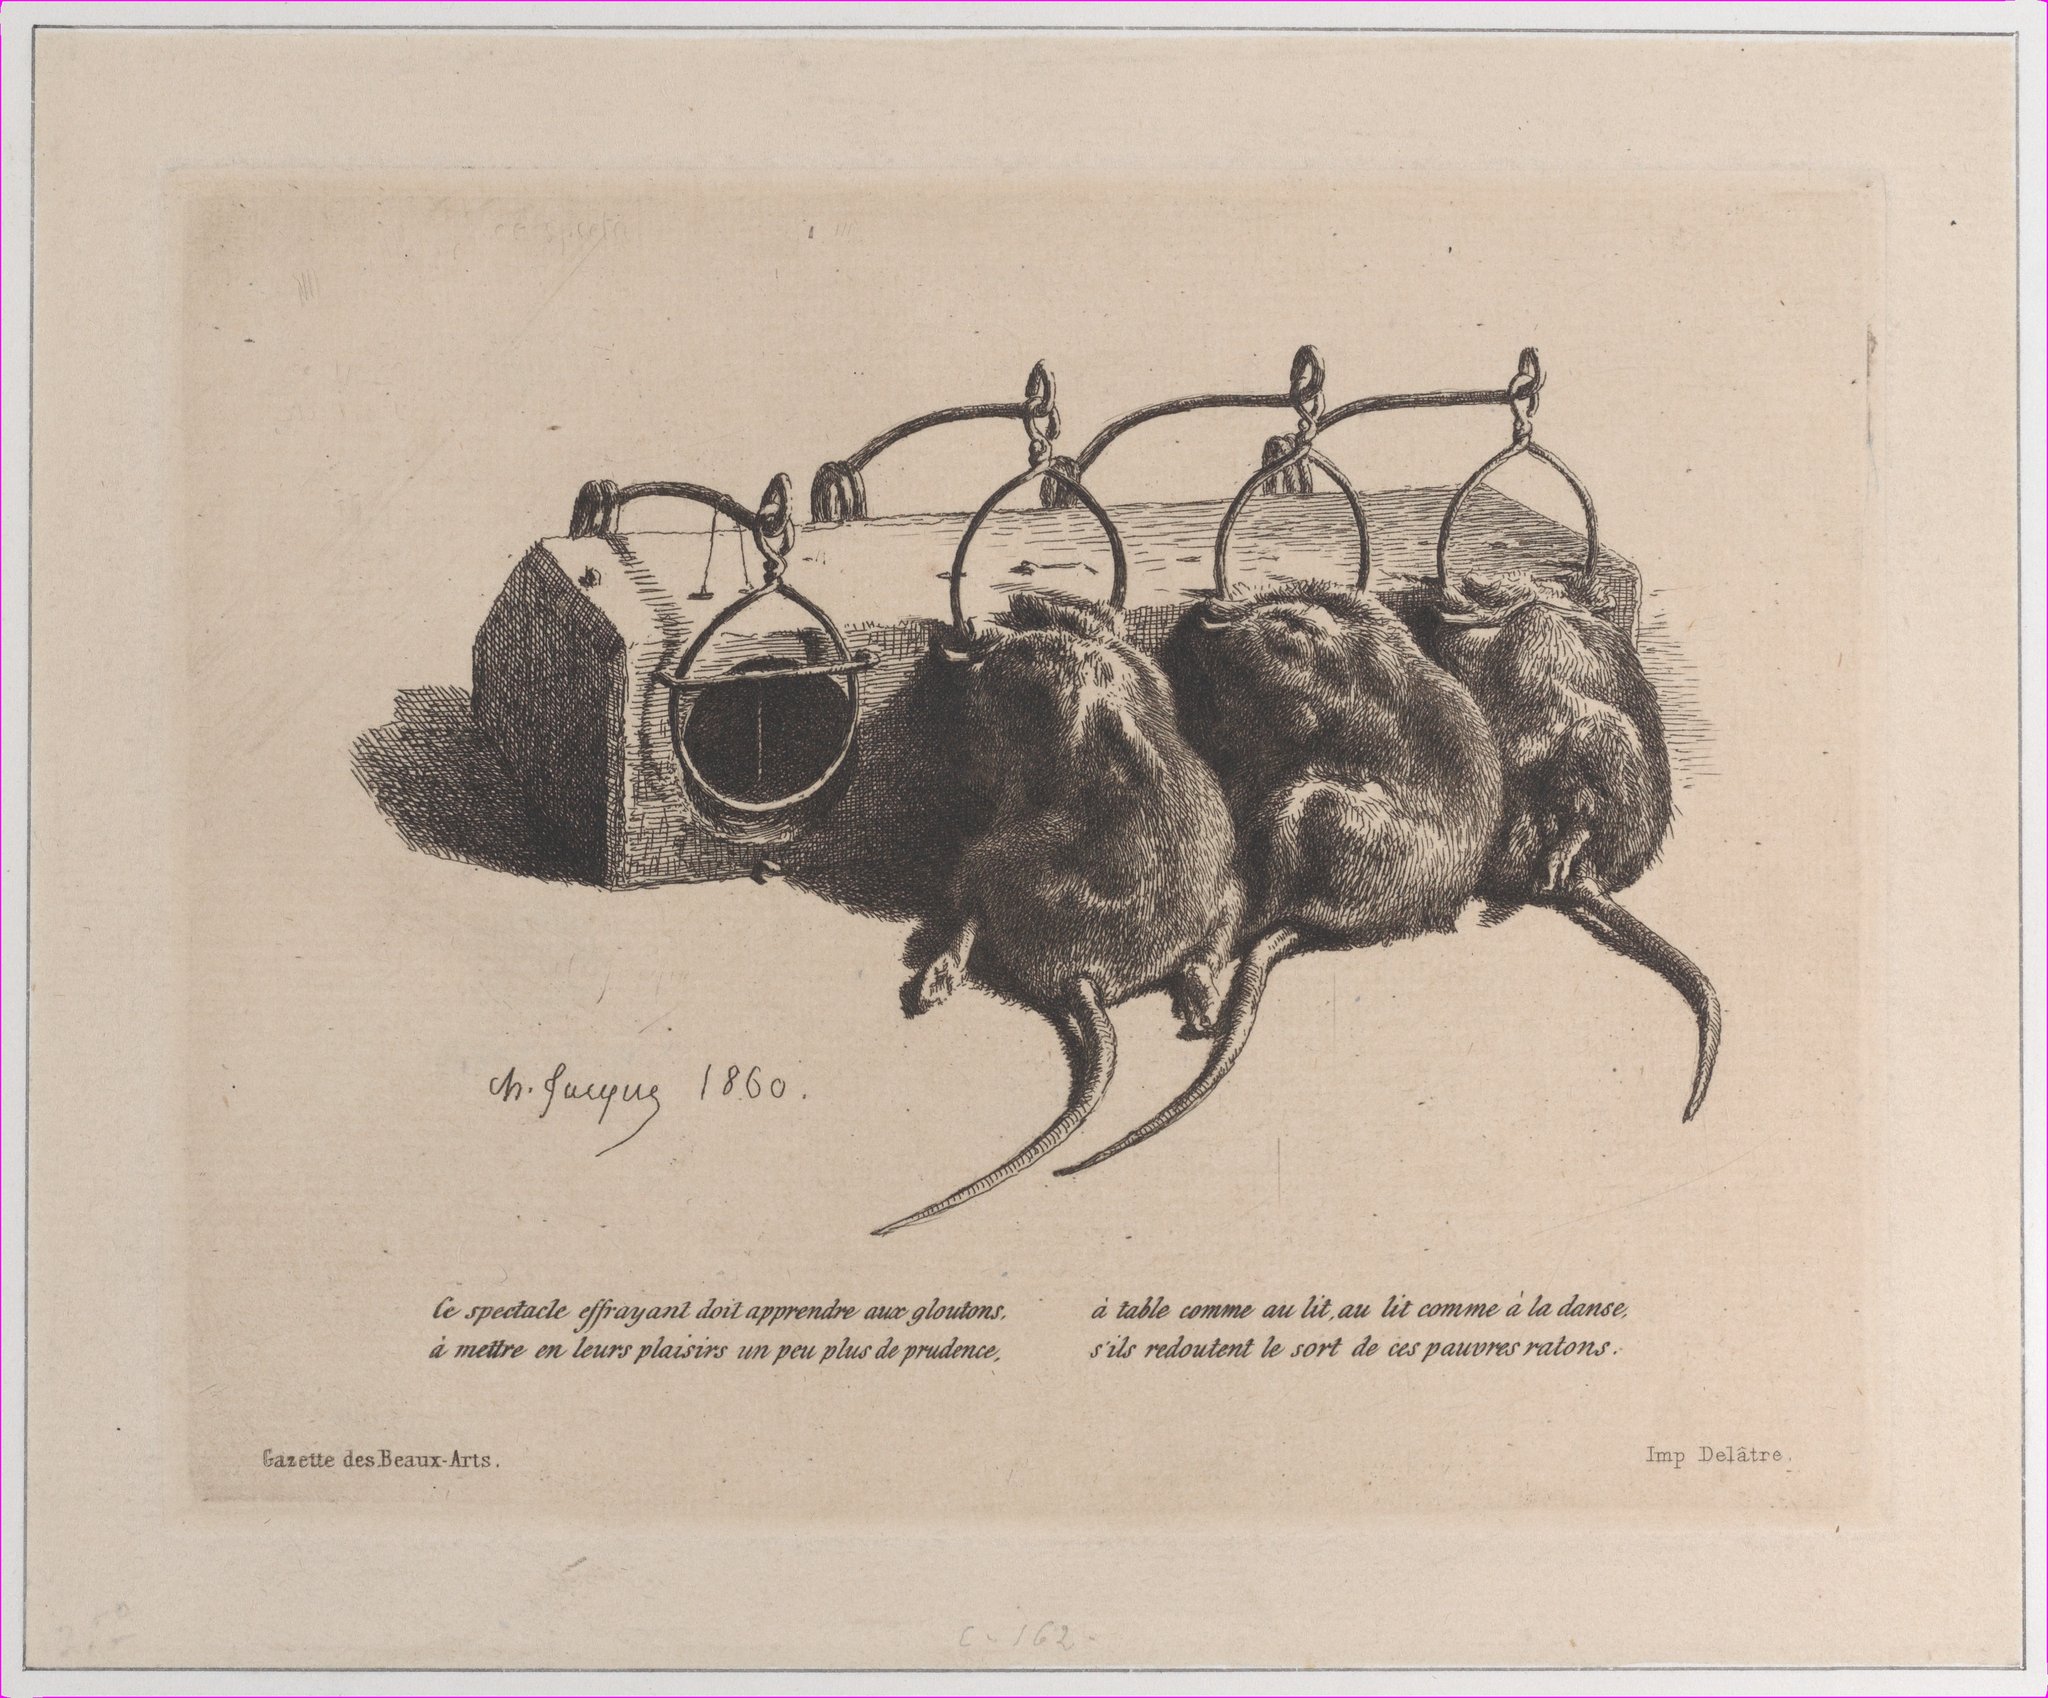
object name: print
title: Mousetrap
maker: charles émile jacque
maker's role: artist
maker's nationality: french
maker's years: 1813-1894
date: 1860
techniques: etching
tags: mice